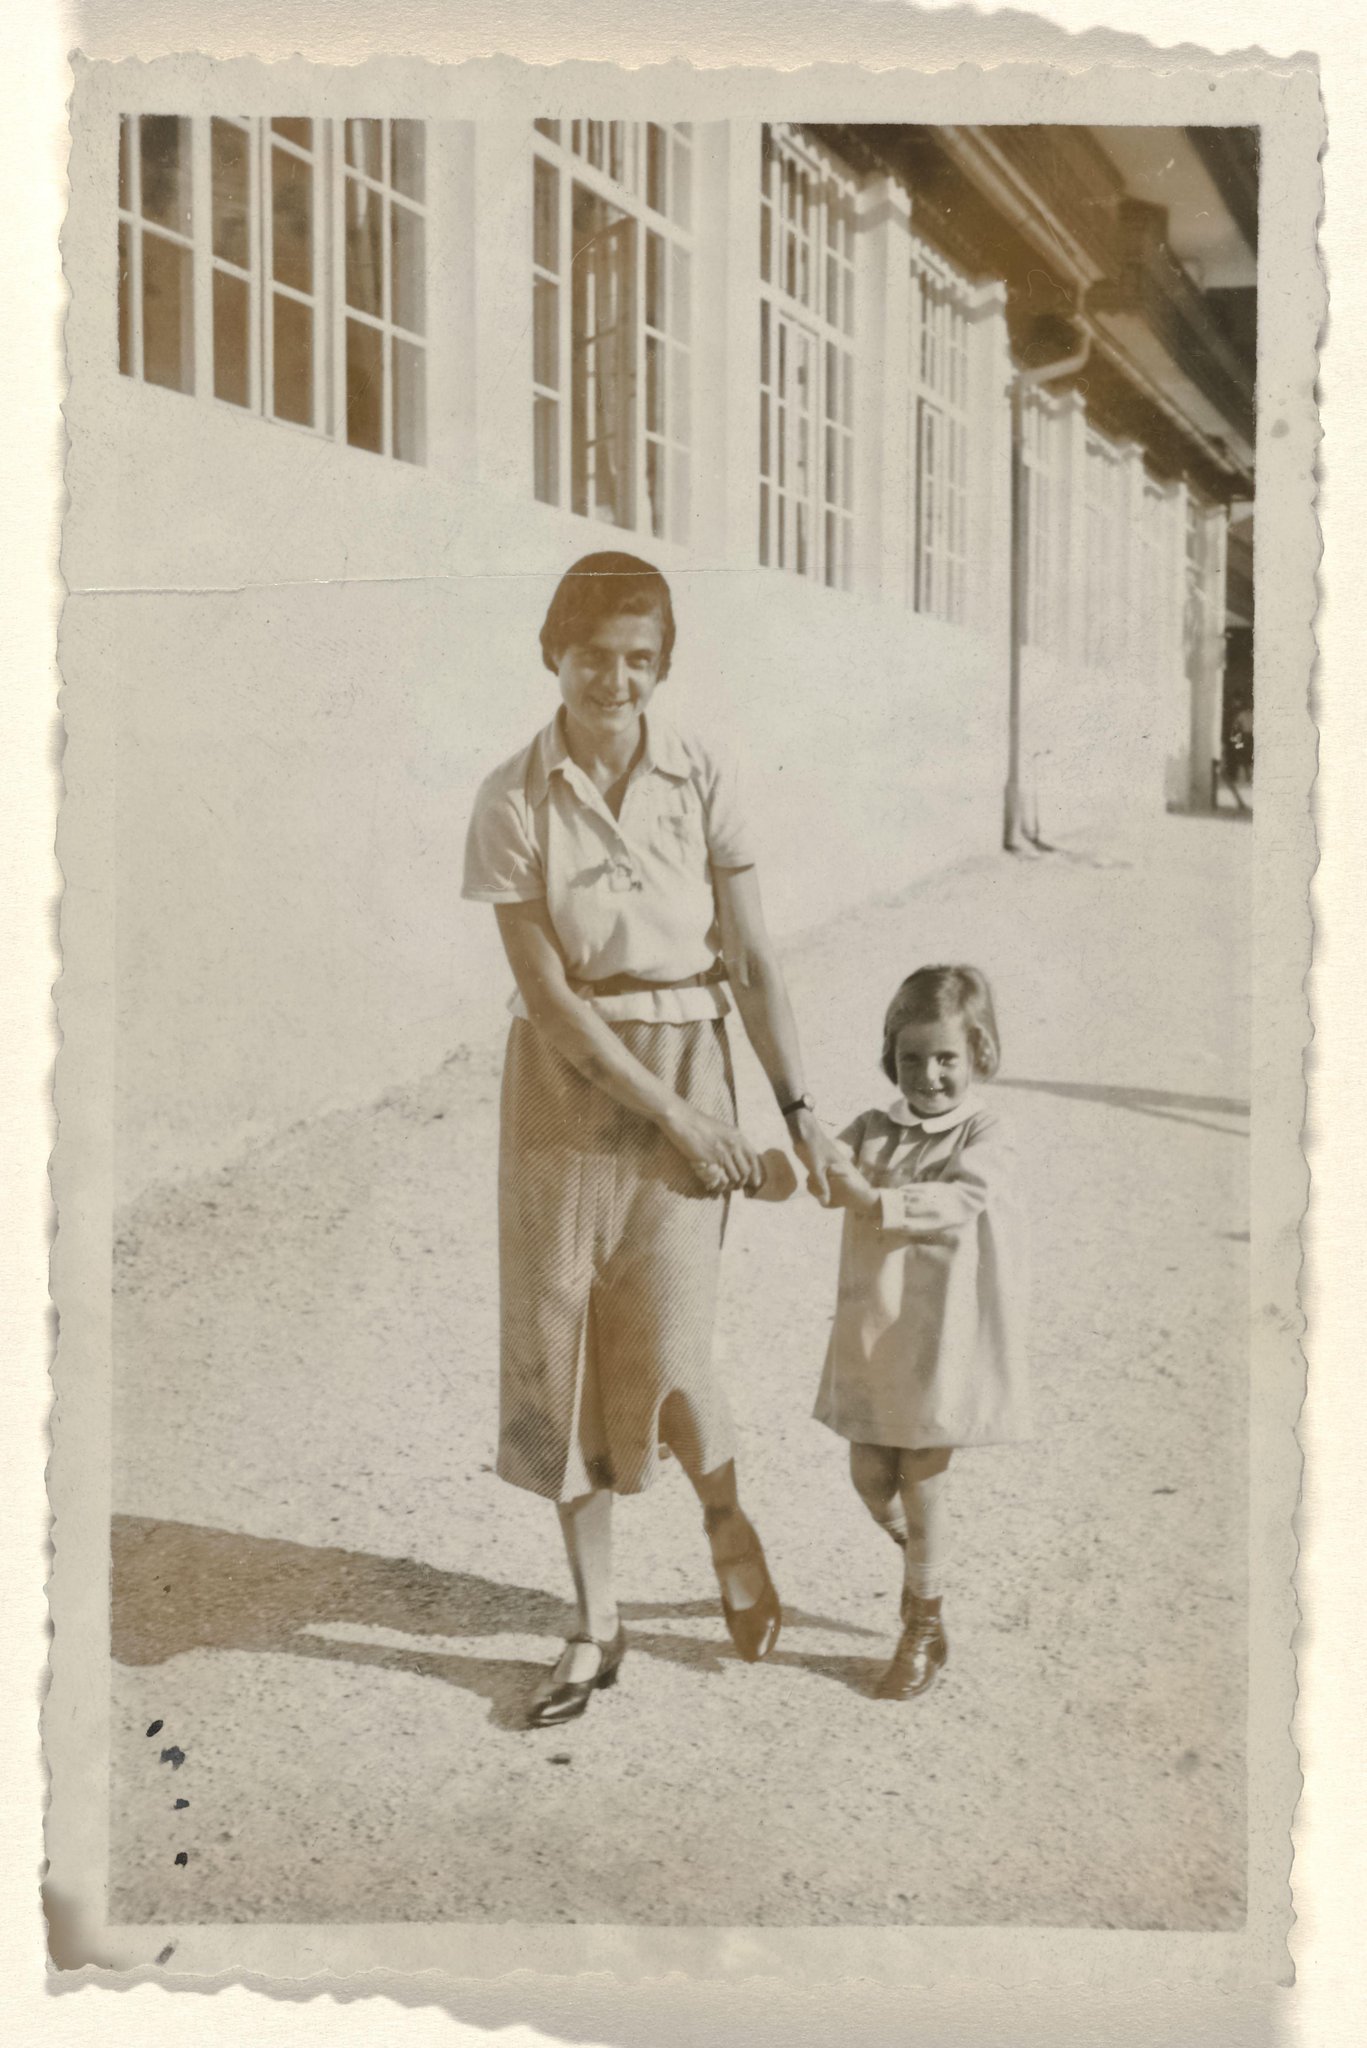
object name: photograph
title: Isabel Wachenheimer lopend aan de hand van een onbekend lid van de huishoudelijke staf, in de buurt van een hotel bij de Eibsee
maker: Anonymous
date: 1908-1932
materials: photographic support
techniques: gelatin silver print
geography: germany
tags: leiden, isabel wachenheimer-elon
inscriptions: inscription: ‘Aug.32 Vor dem Hotel am Eibsee Eins, Zwei!’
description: Dit object is onderdeel van de nalatenschap van Isabel Elon-Wachenheimer (1928-2010). Tot haar overlijden behoorde het samen met de andere objecten uit de nalatenschap tot haar privédomein van Isabel Wachenheimer. In die particuliere context zijn deze objecten tezamen en individueel aandenkens - aan de jeugd, ouders en familie van Isabel Wachenheimer vóór en tijdens de Shoah en aan haar leven na de Tweede Wereldoorlog. Isabel Wachenheimer, die van juni 1943 tot mei 1945 gevangen zat in Kamp Westerbork, Theresienstadt, Auschwitz, Lenzing a/d Oberdonau (een buitenkamp van Mauthausen), overleefde de Shoah. Haar ouders – Eugène Wachenheimer en Else Wachenheimer-Moos - werden op 14 oktober 1944 in Auschwitz-Birkenau vermoord.